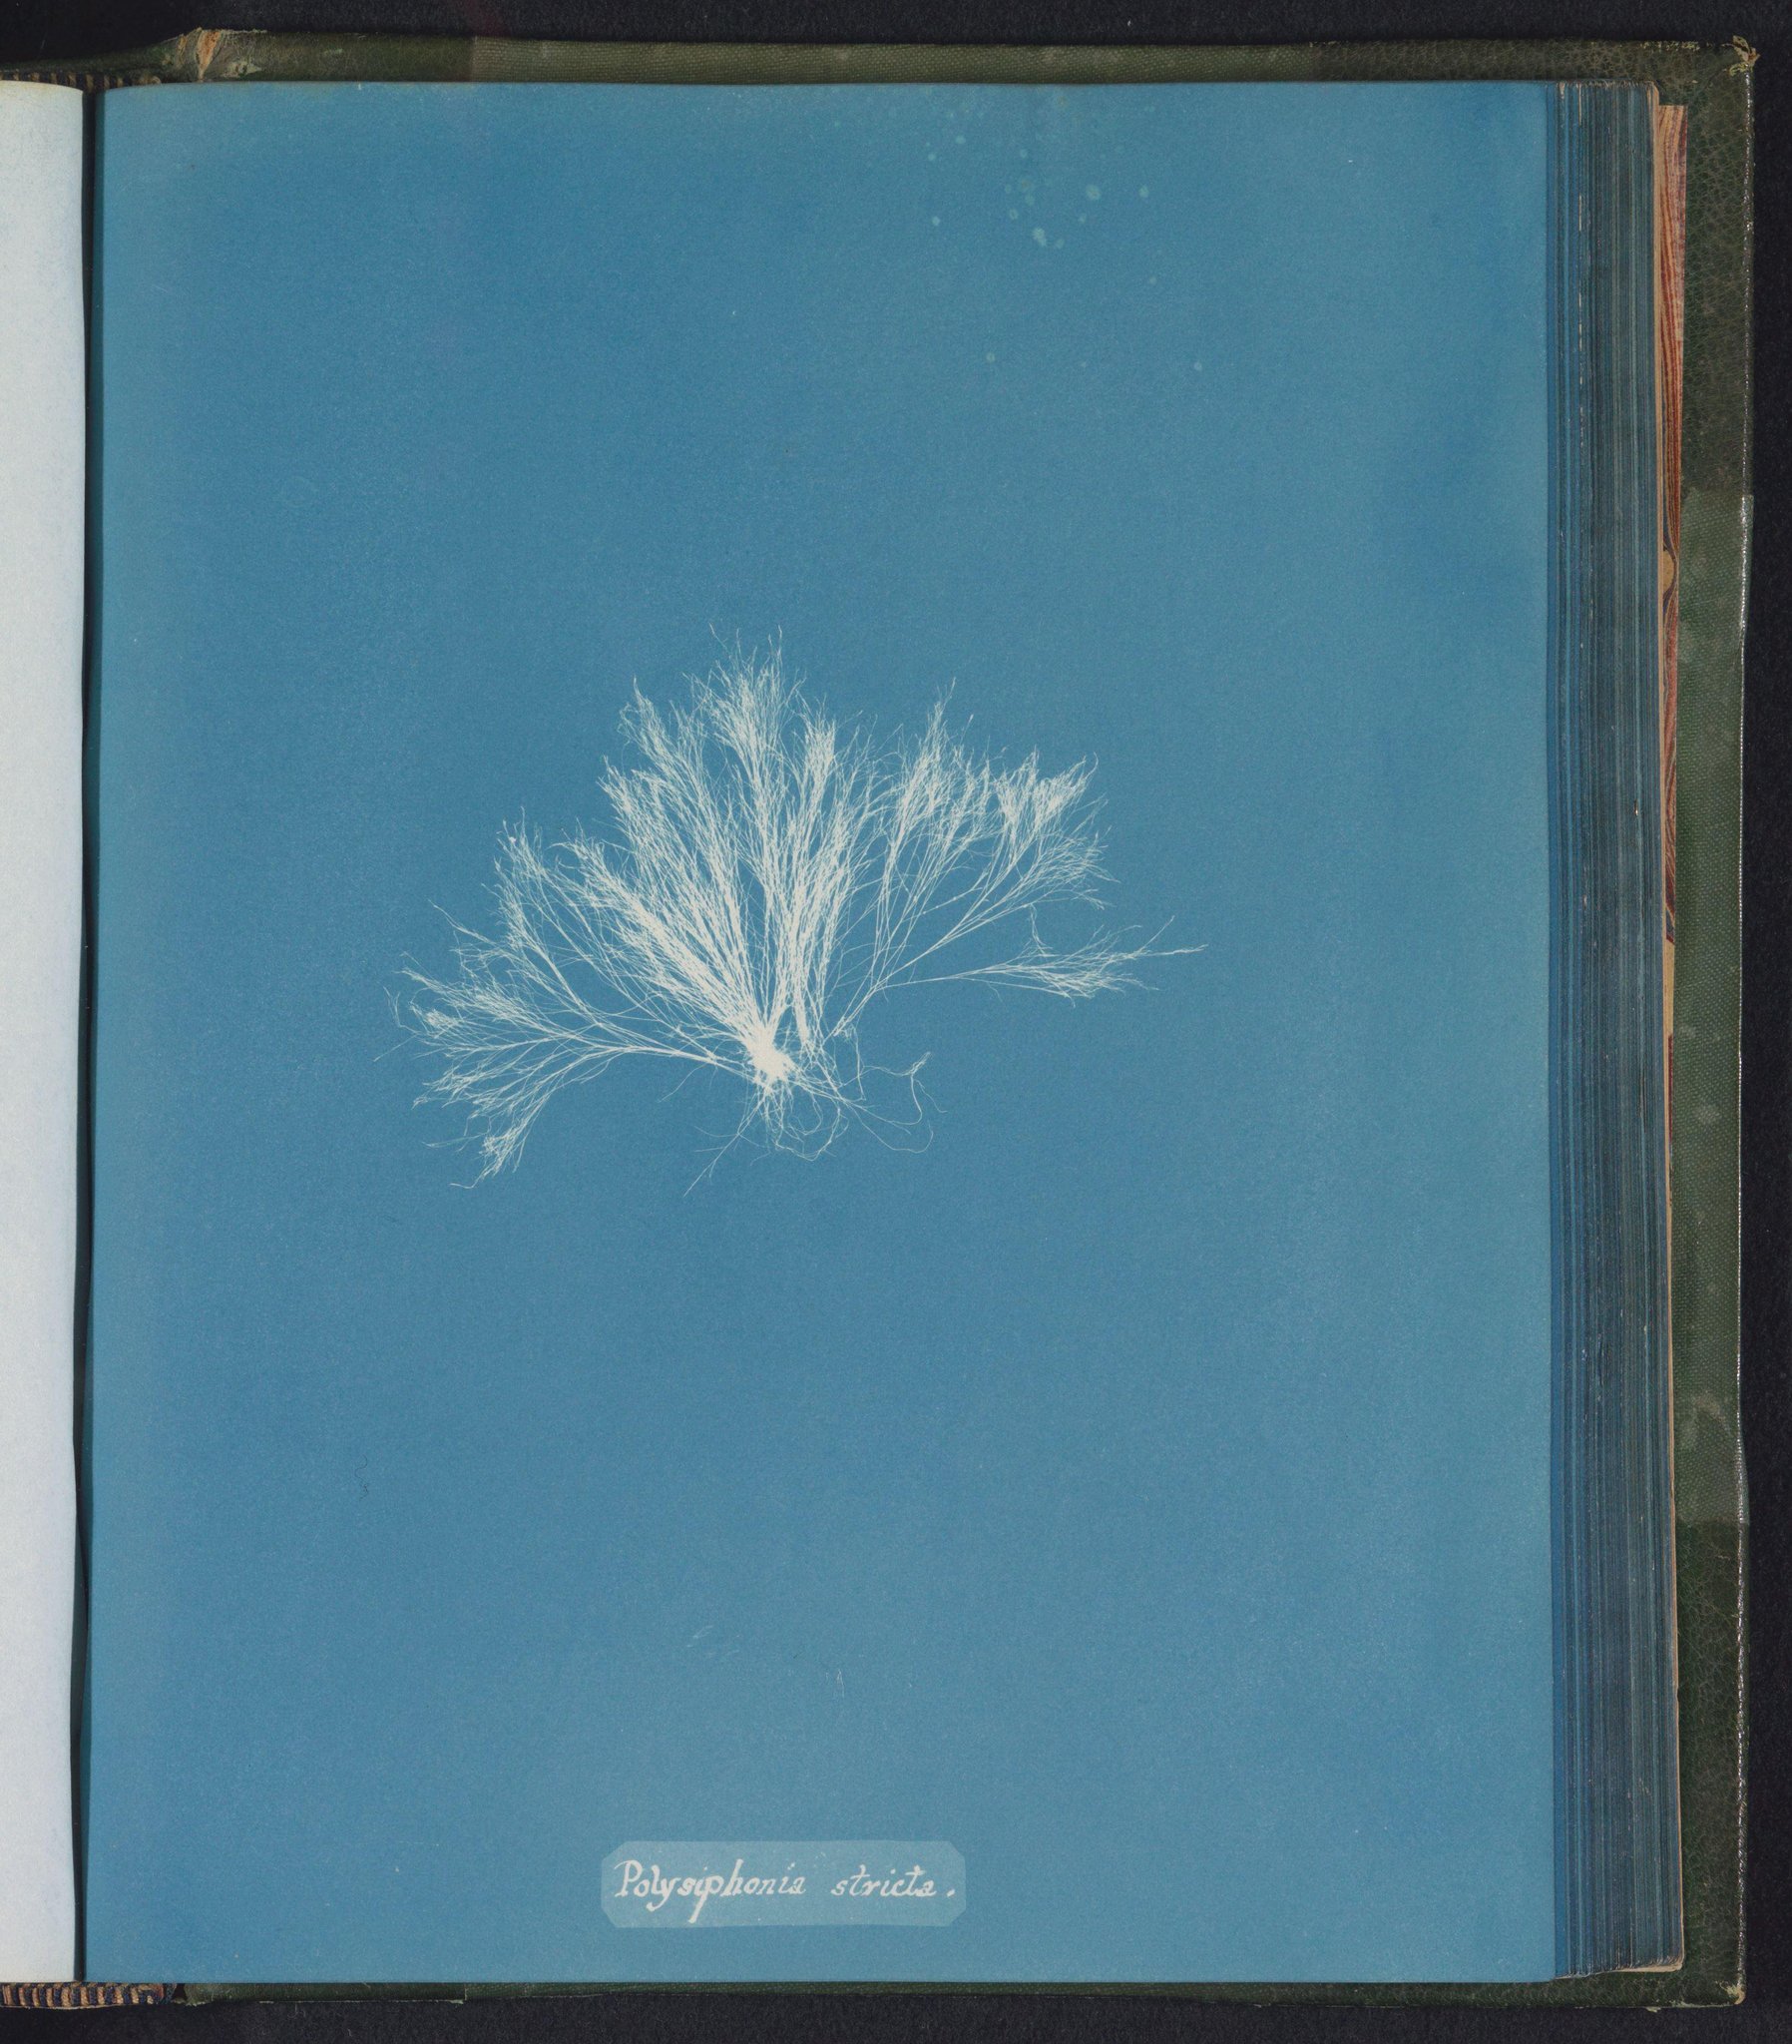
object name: photograph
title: Zeewier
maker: anna atkins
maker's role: fotograaf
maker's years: 1799-1871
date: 1843-1853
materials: photographic support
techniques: cyanotype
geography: united kingdom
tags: algae, seaweed